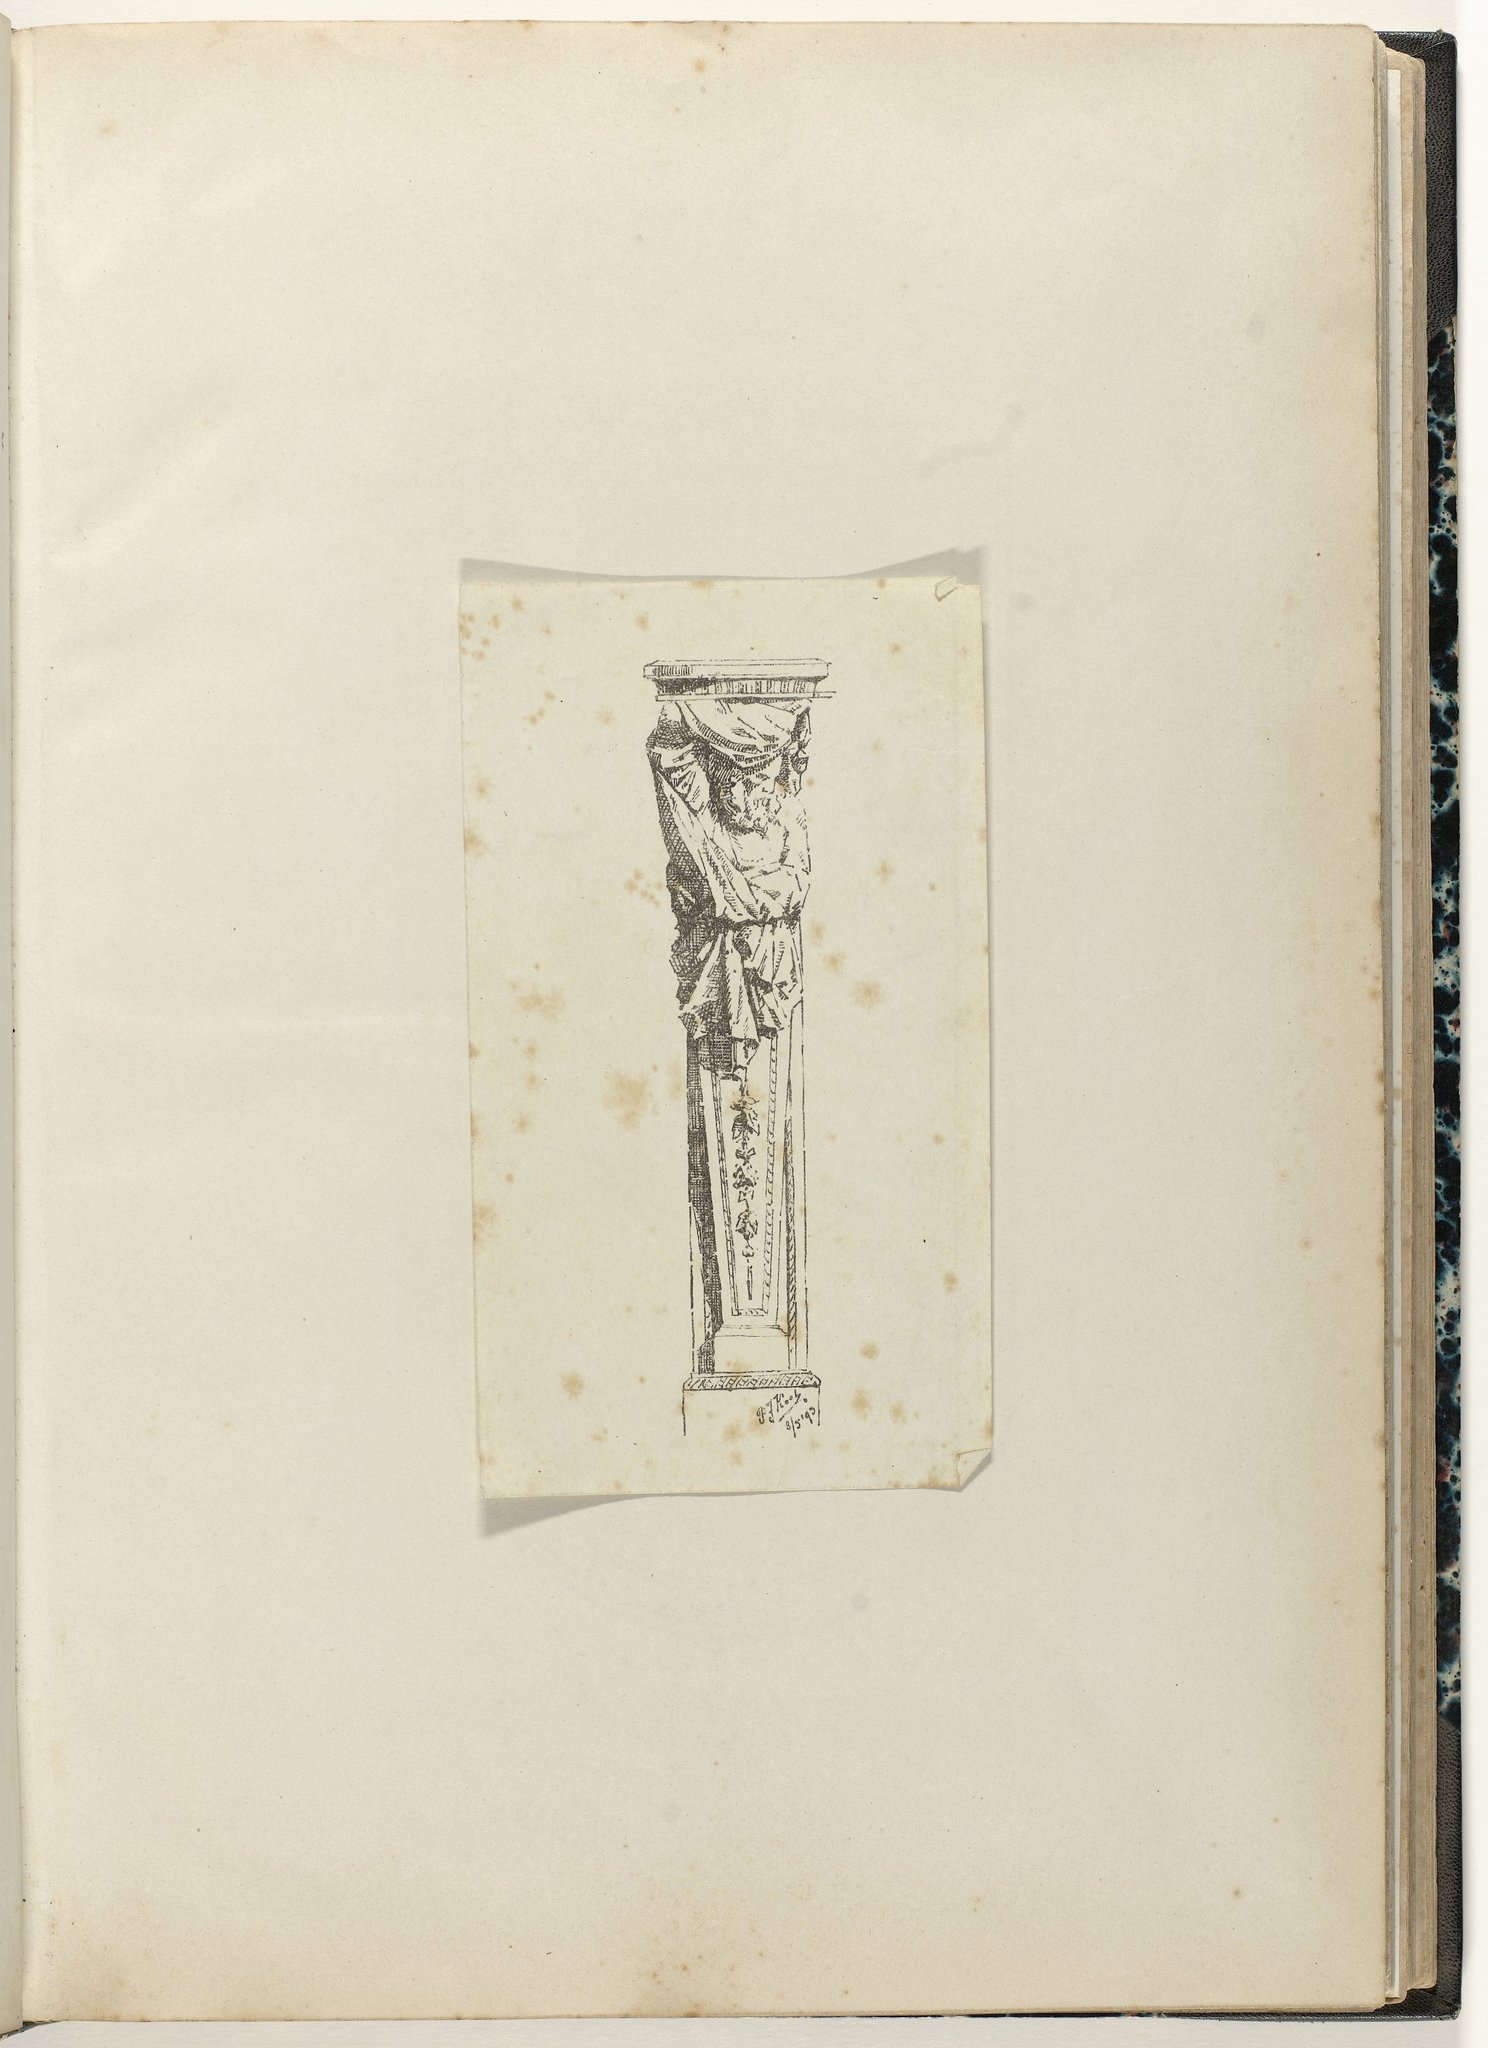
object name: print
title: Mannelijke herme met baard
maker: p.j. kool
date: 1893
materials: paper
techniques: engraving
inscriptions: date